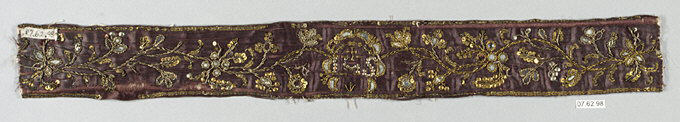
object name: strip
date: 1701-1800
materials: silk